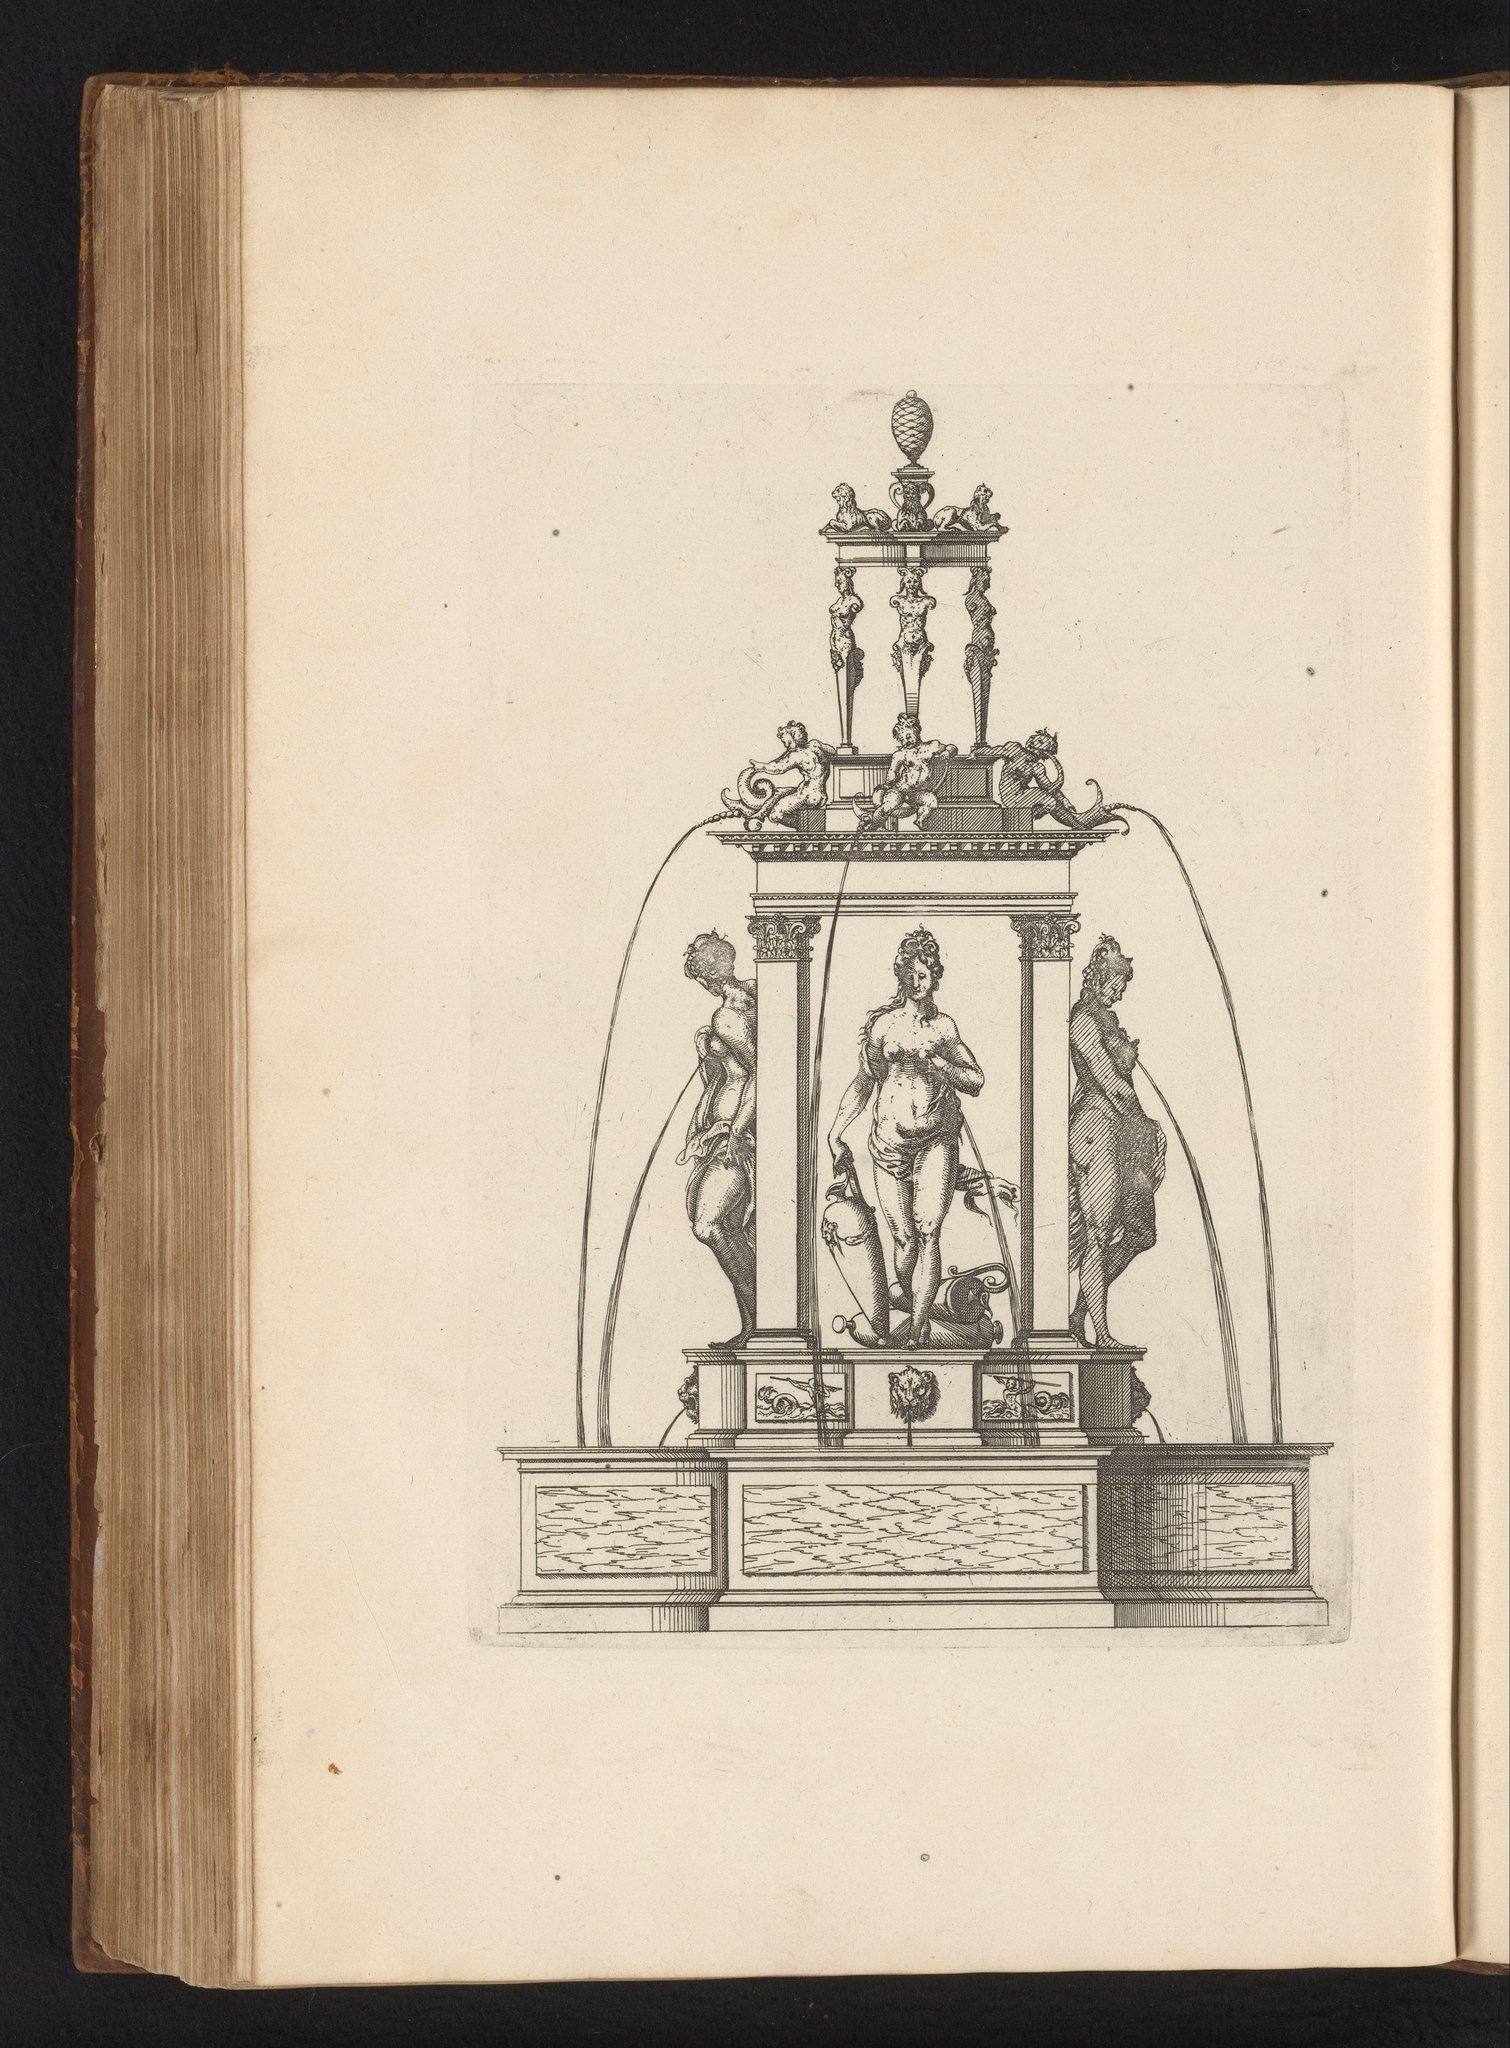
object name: ornament print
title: Fontein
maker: jacques androuet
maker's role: draughtsman, print maker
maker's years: 1515-1584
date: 1561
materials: paper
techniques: etching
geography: paris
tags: garden fountain, piece of sculpture, reproduction of a piece of sculpture, ornamental fountain, architectural design or model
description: Fontein met drie vrouwenfiguren en drie putti met schelpen. Onderdeel van 'Seconde livre d'architectvre' (1561): 64 etsen met geornamenteerde architectuuronderdelen.